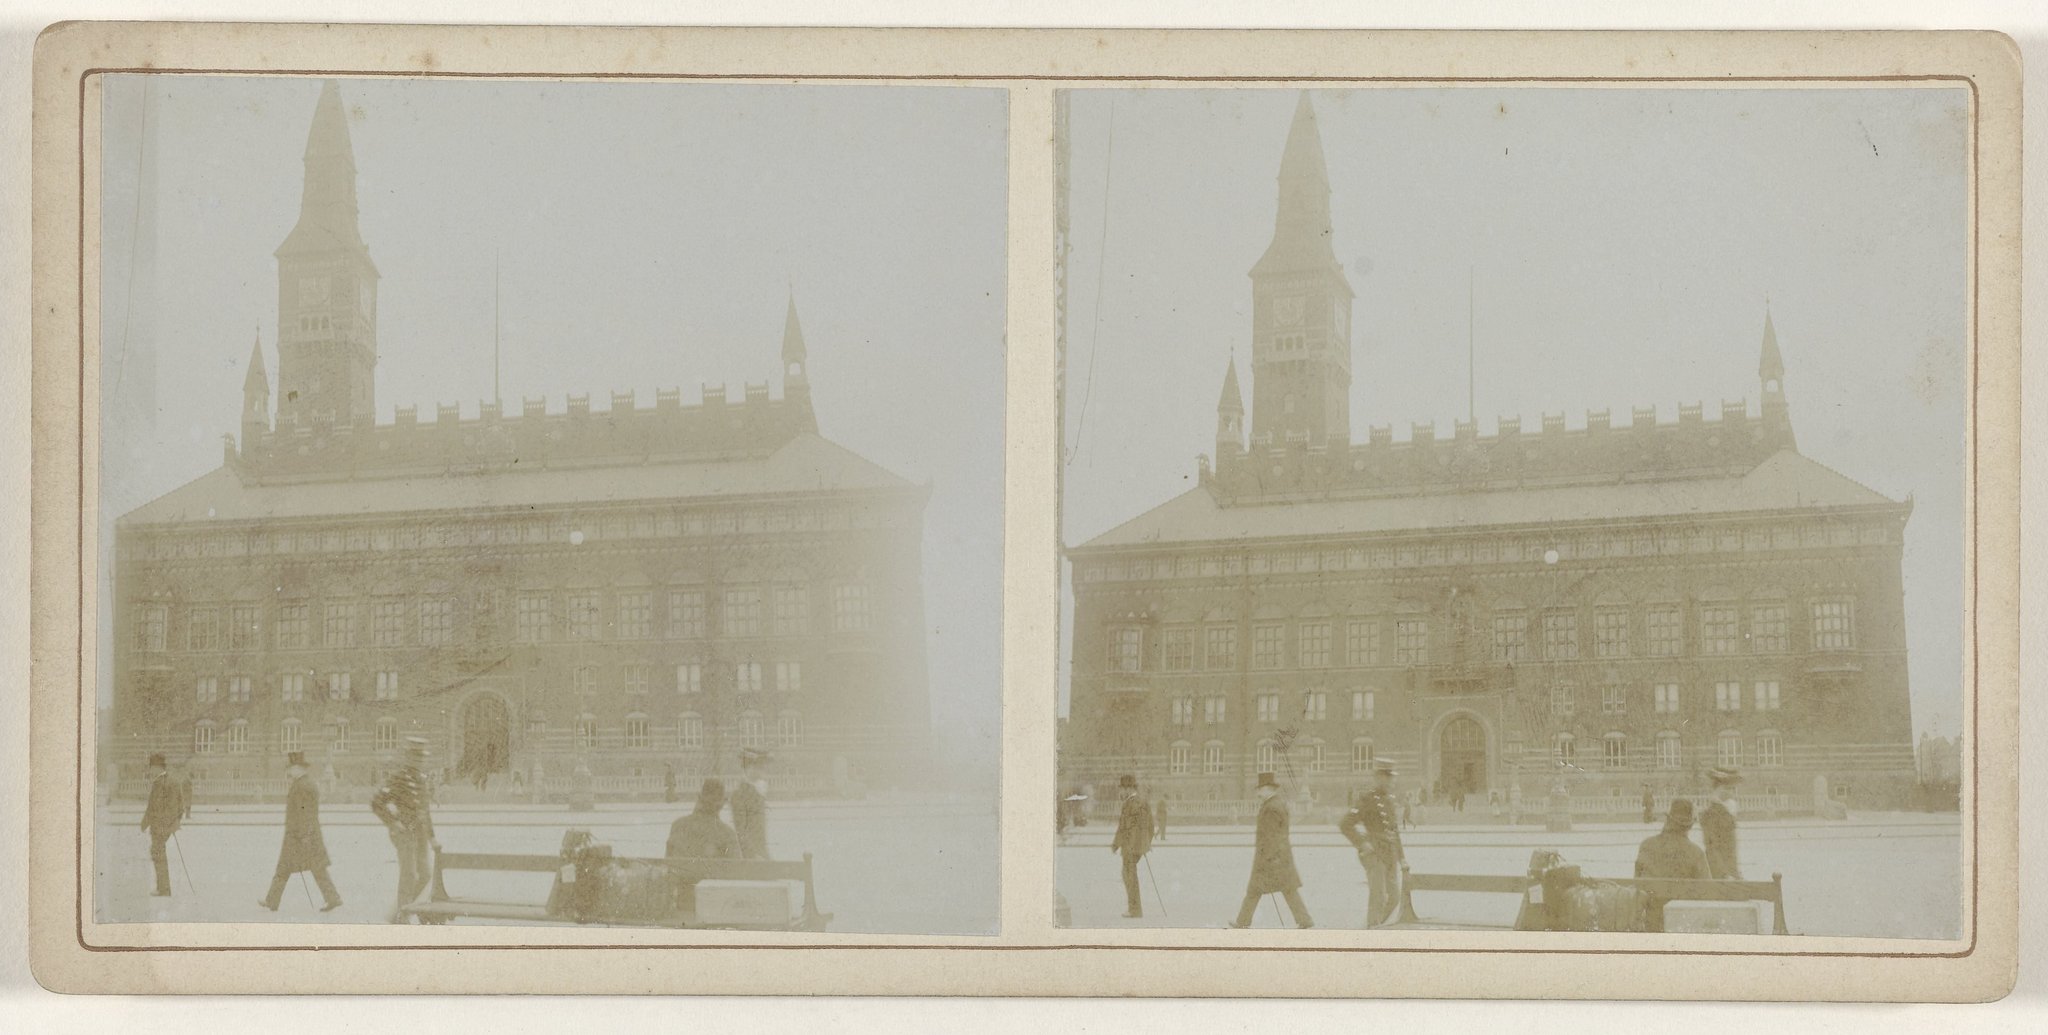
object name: stereograph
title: Stadhuis te Kopenhagen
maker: geldolph adriaan kessler (dolph)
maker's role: fotograaf, industrieel, voetballer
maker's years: 1884-1945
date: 1903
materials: paper, photographic support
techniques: collodion silver print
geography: potsdam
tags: copenhagen (city)